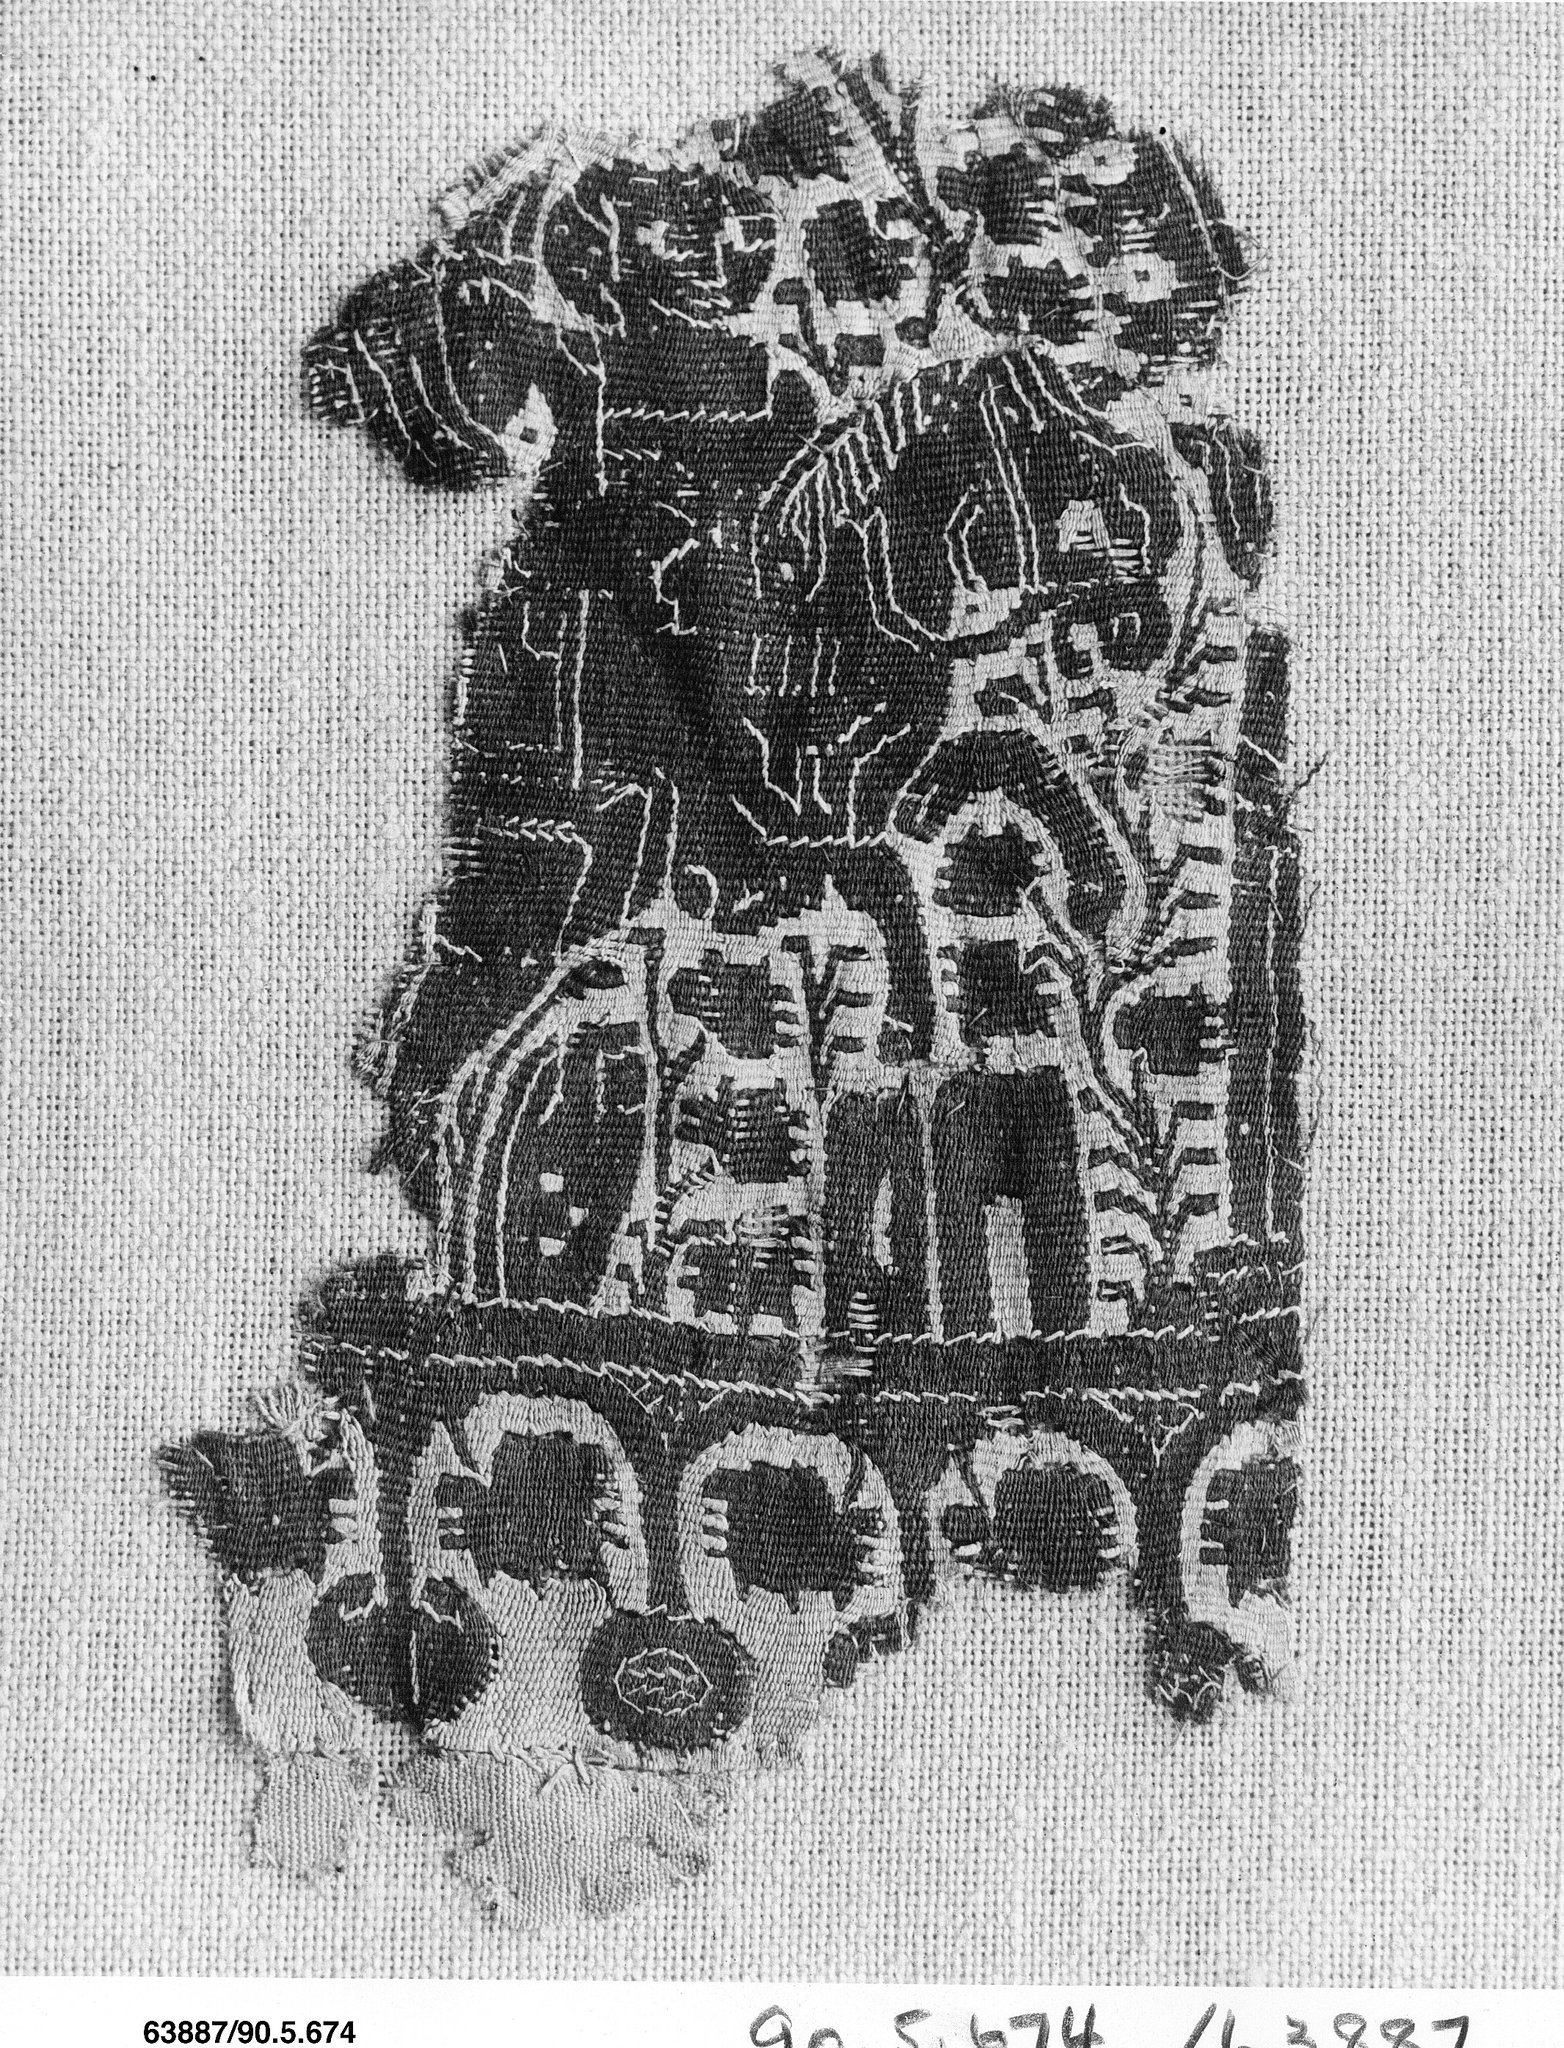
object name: textile fragment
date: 301-400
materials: linen, wool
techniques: weave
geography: egypt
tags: horses